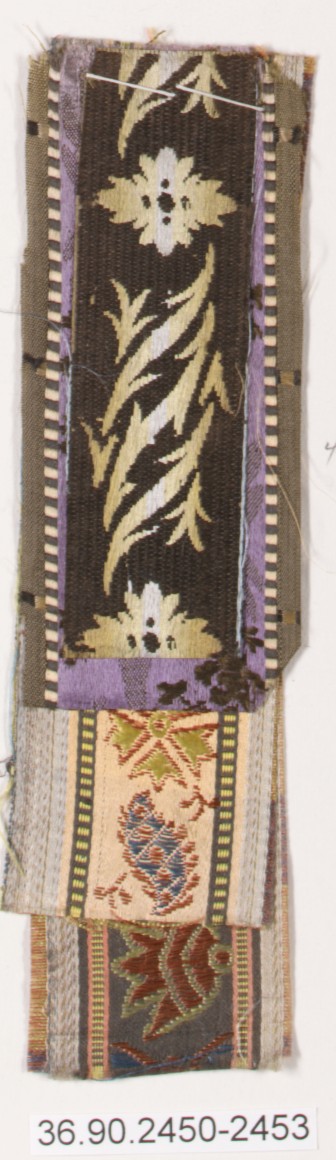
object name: ribbon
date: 1801-1900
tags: flowers